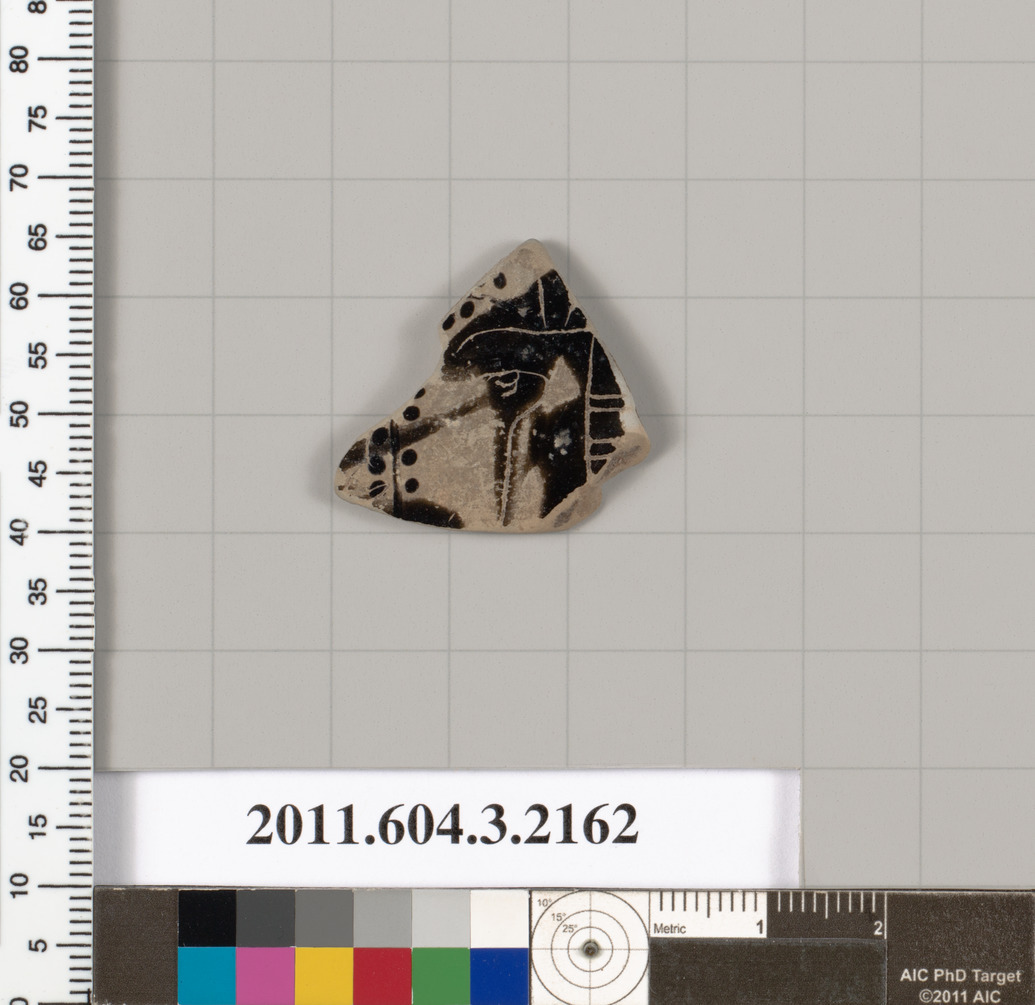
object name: kylix fragment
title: Terracotta fragment of a kylix (drinking cup)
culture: greek, attic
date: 534-501 BCE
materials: terracotta